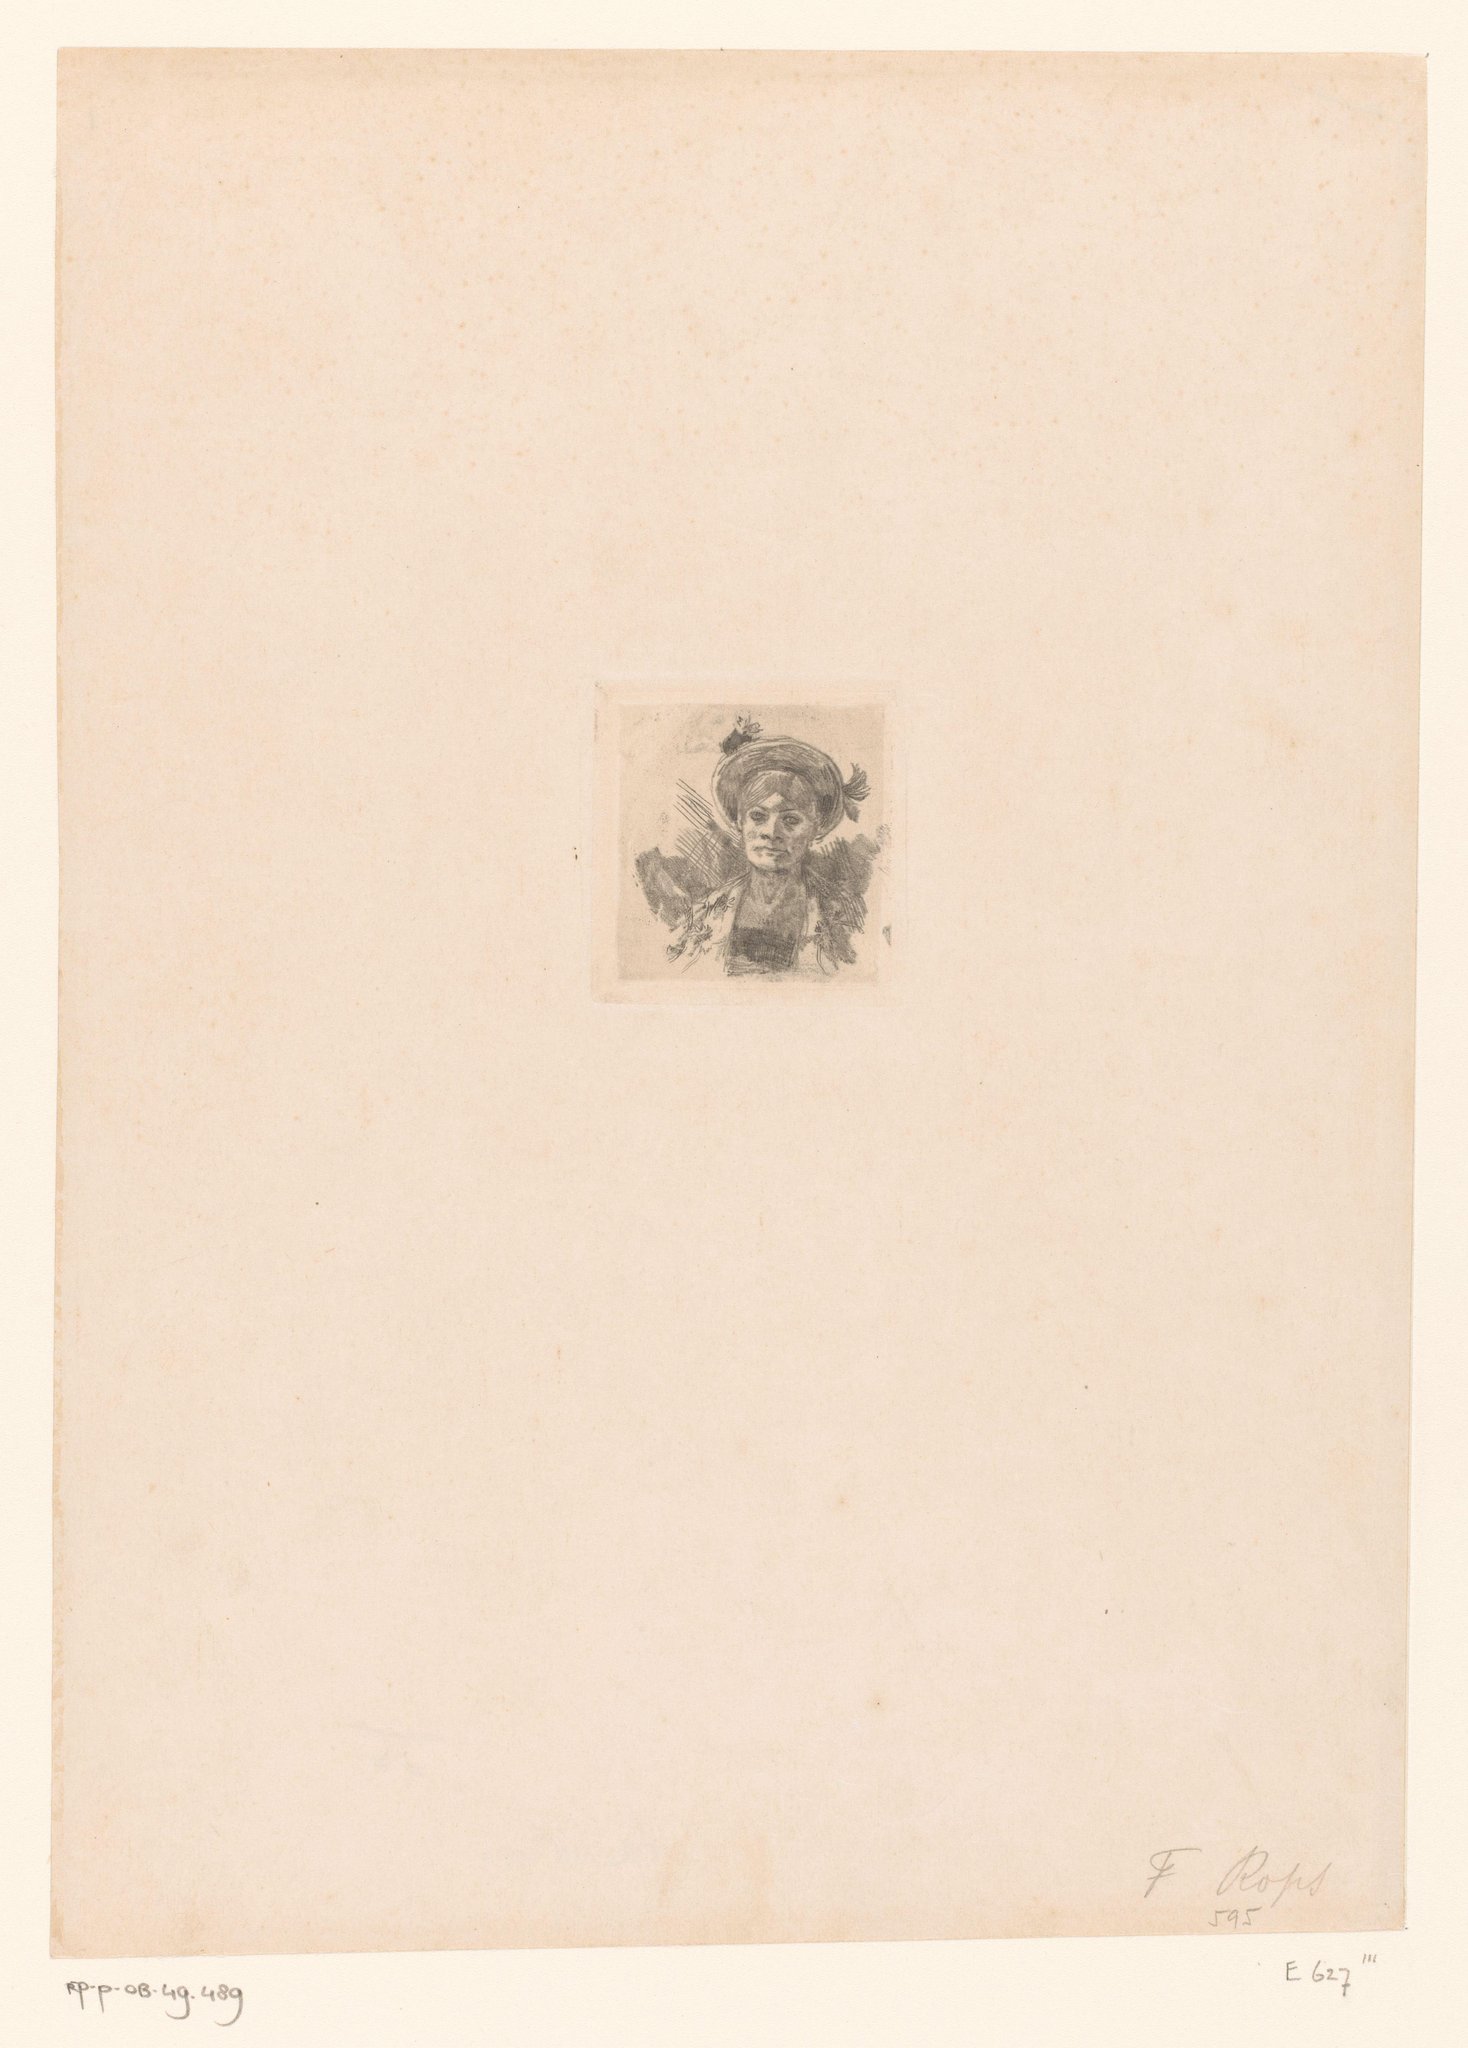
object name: print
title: Portret van een onbekende vrouw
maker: félicien rops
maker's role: draughtsman, print maker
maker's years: 1833-1898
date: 1895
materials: paper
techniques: soft ground etching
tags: adult woman